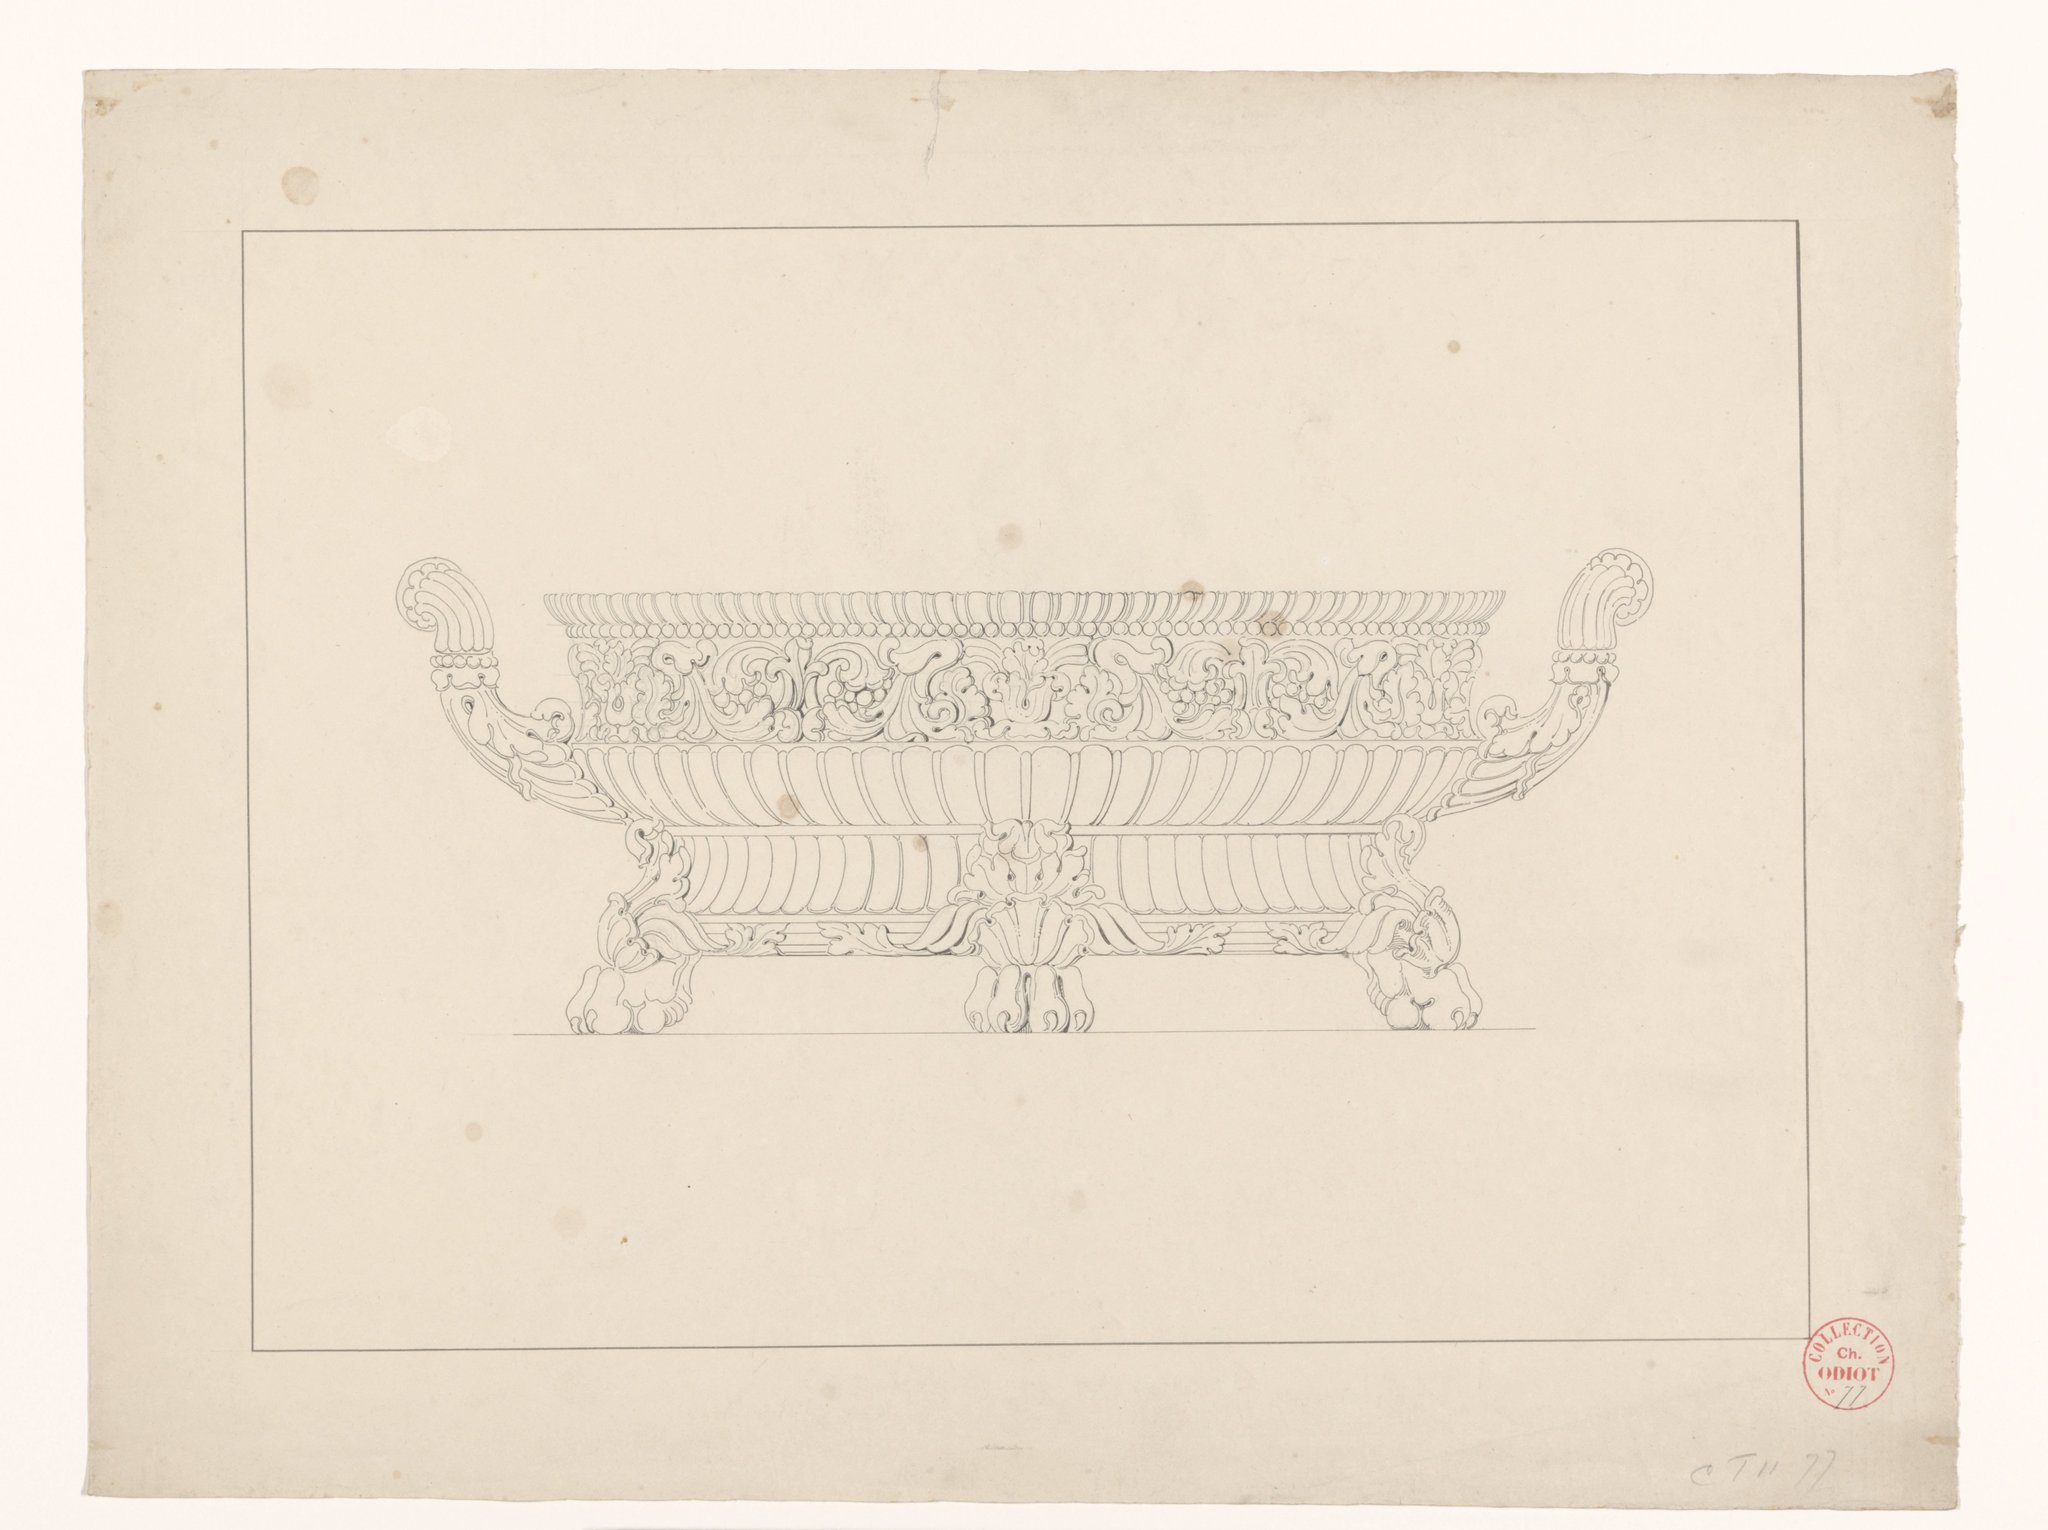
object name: design drawing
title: Ontwerp voor een réchaud (op ware grootte)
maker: charles nicolas odiot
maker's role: jeweler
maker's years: 1789-1869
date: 1825-1830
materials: ink, paper, pencil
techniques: brush, drawing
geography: paris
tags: dinner-service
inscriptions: inscription: ‘CT 11 No 77.’, stamp